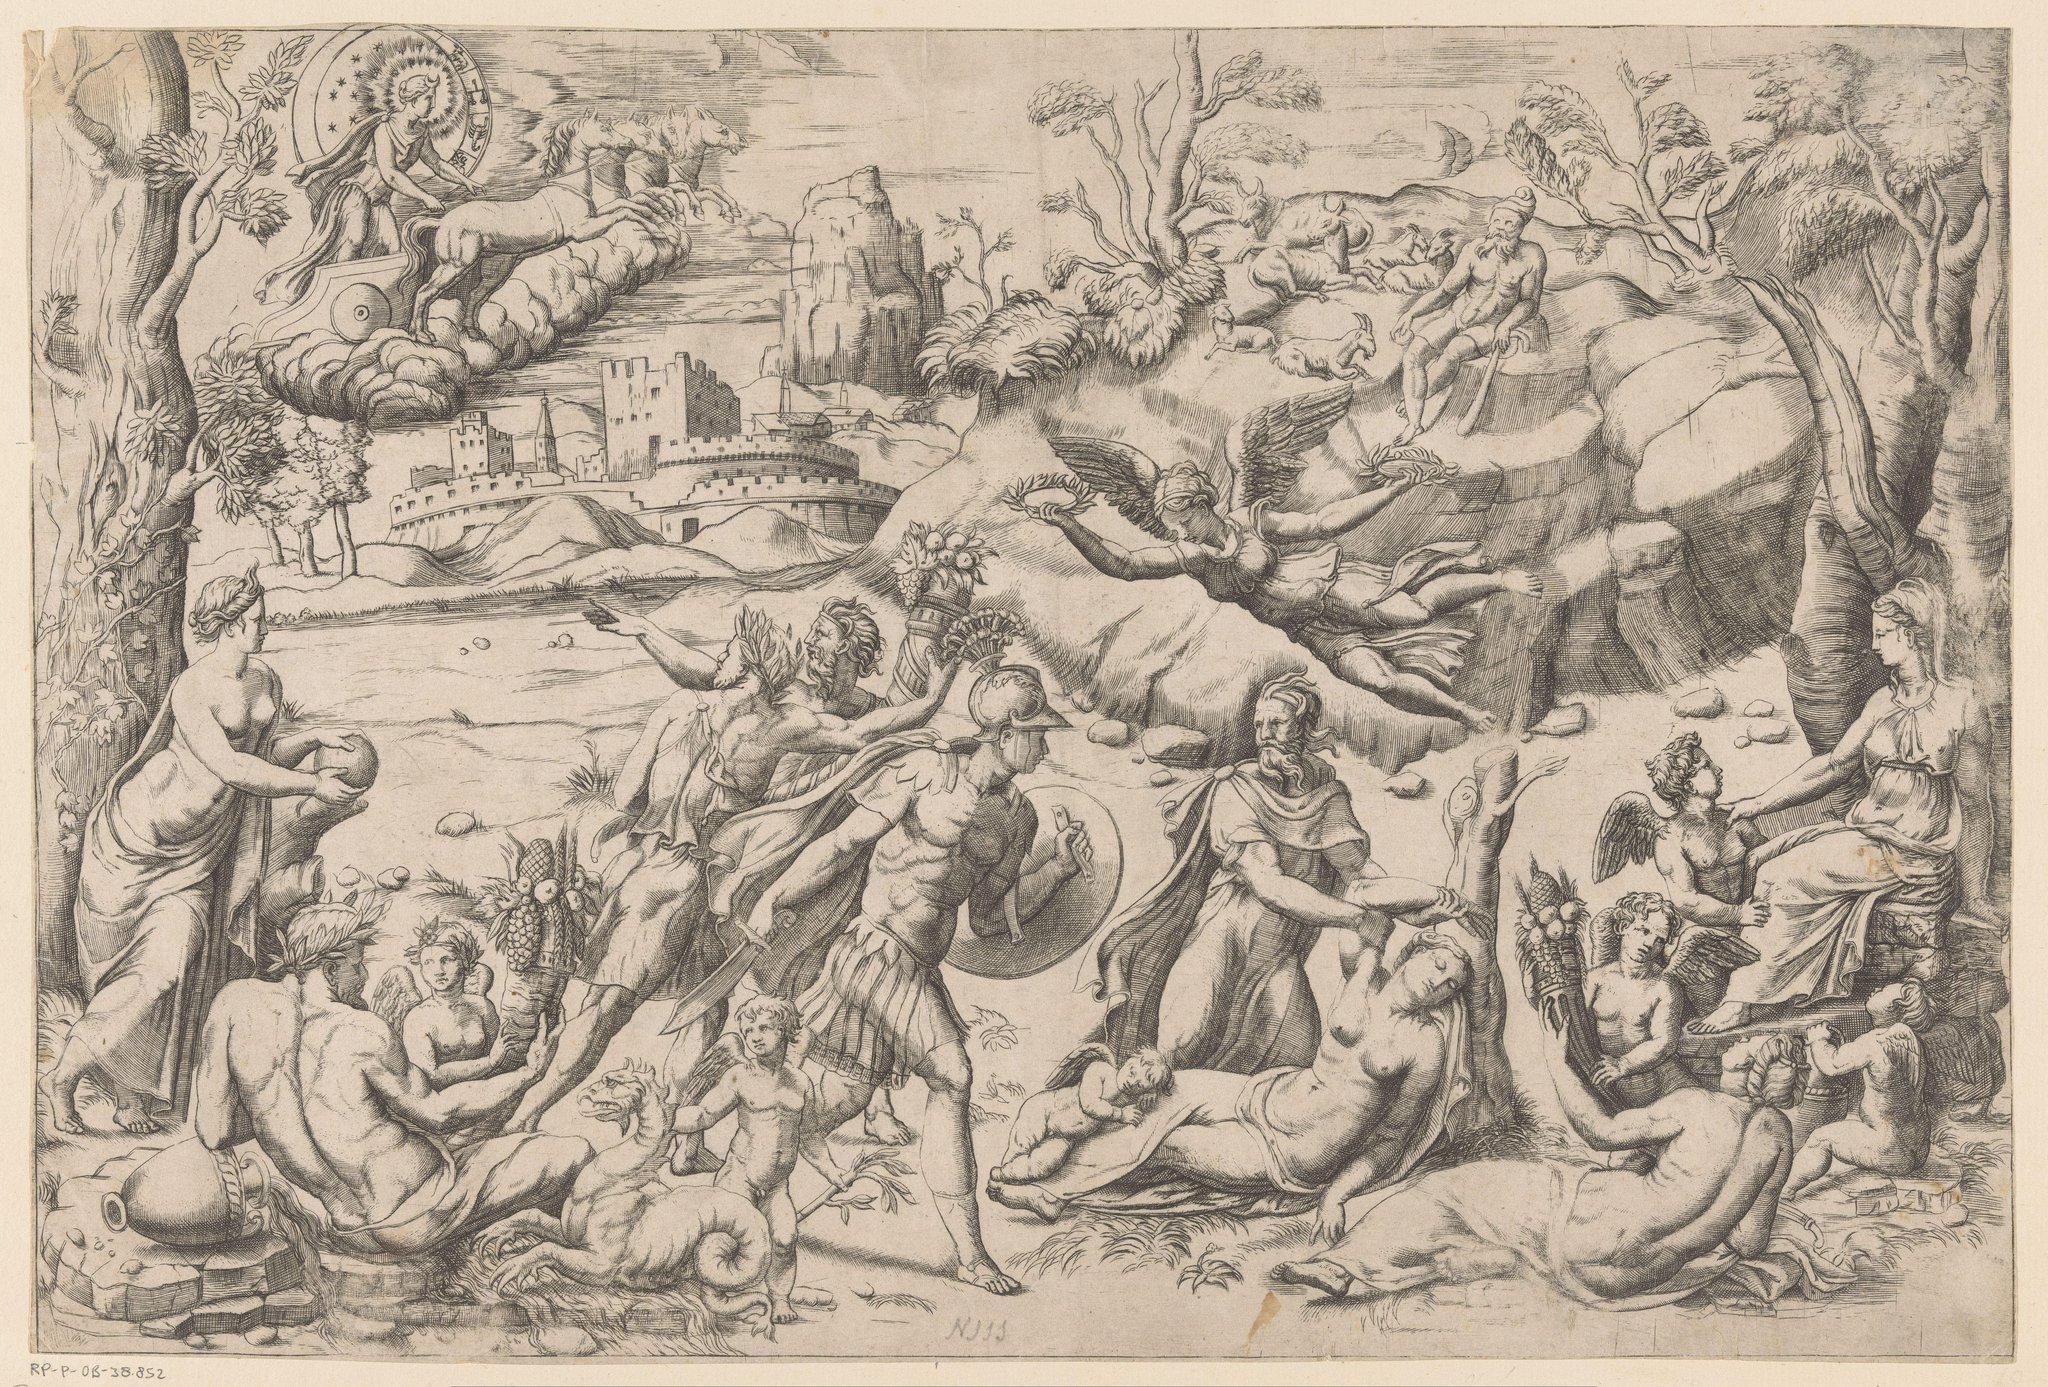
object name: print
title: Mythologische voorstelling met een ingeslapen vrouw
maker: Anonymous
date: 1500-1599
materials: paper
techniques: engraving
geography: italy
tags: city-view, and landscape with man-made constructions, 'cornucopia', horn of plenty, diana as moon-goddess, i.e. luna (selene), river-gods, cupids: 'amores', 'amoretti', 'putti', herd, flock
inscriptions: collector's mark: Lugt 240, inscription: ‘f. 220:4: A Veneziano’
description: In een landschap ligt een ingeslapen vrouw tegen een boom. Een strijder in harnas nadert haar, gevolgd door twee mannen met een hoorn des overvloeds (cornucopia). Links op de voorgrond een riviergod en in de lucht Diana als maangodin in een wagen getrokken door paarden. Rechts op een rotspartij zit een herder met zijn kudde.